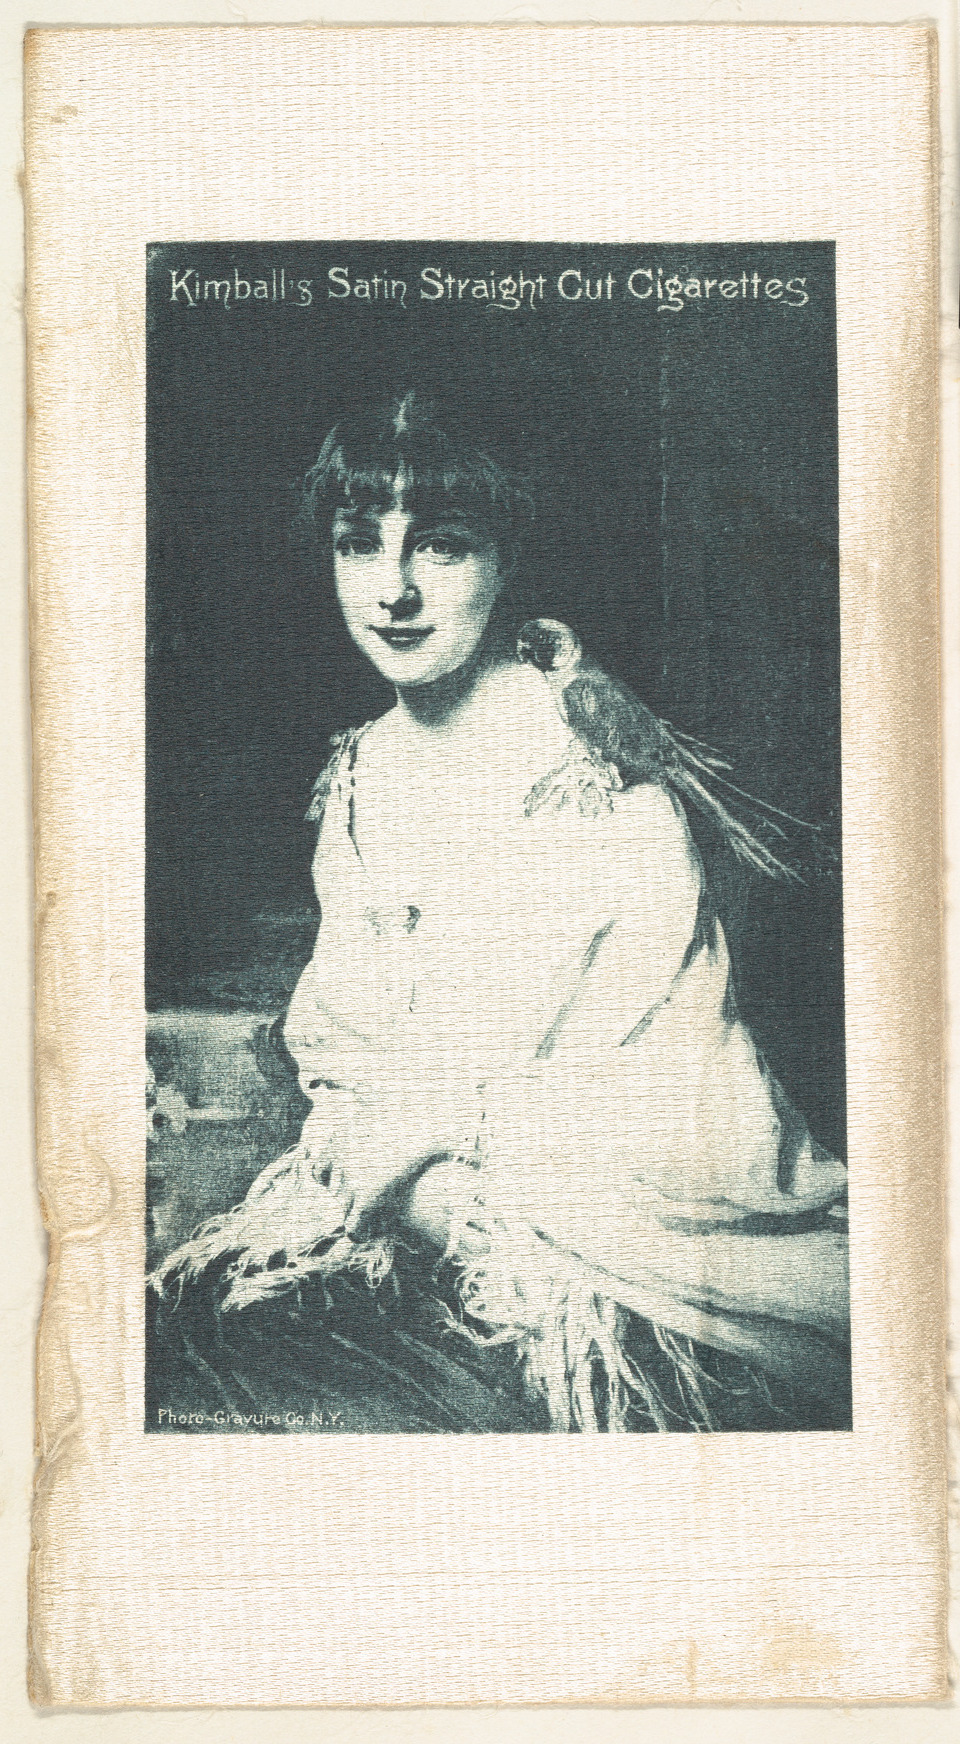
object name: print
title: Seated woman with bird on shoulder (on white silk), from the Girl Art Subjects series (N193) issued by Wm. S. Kimball & Co.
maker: william s. kimball & company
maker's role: publisher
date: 1890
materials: silk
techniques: lithography, printing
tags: birds,portraits,women